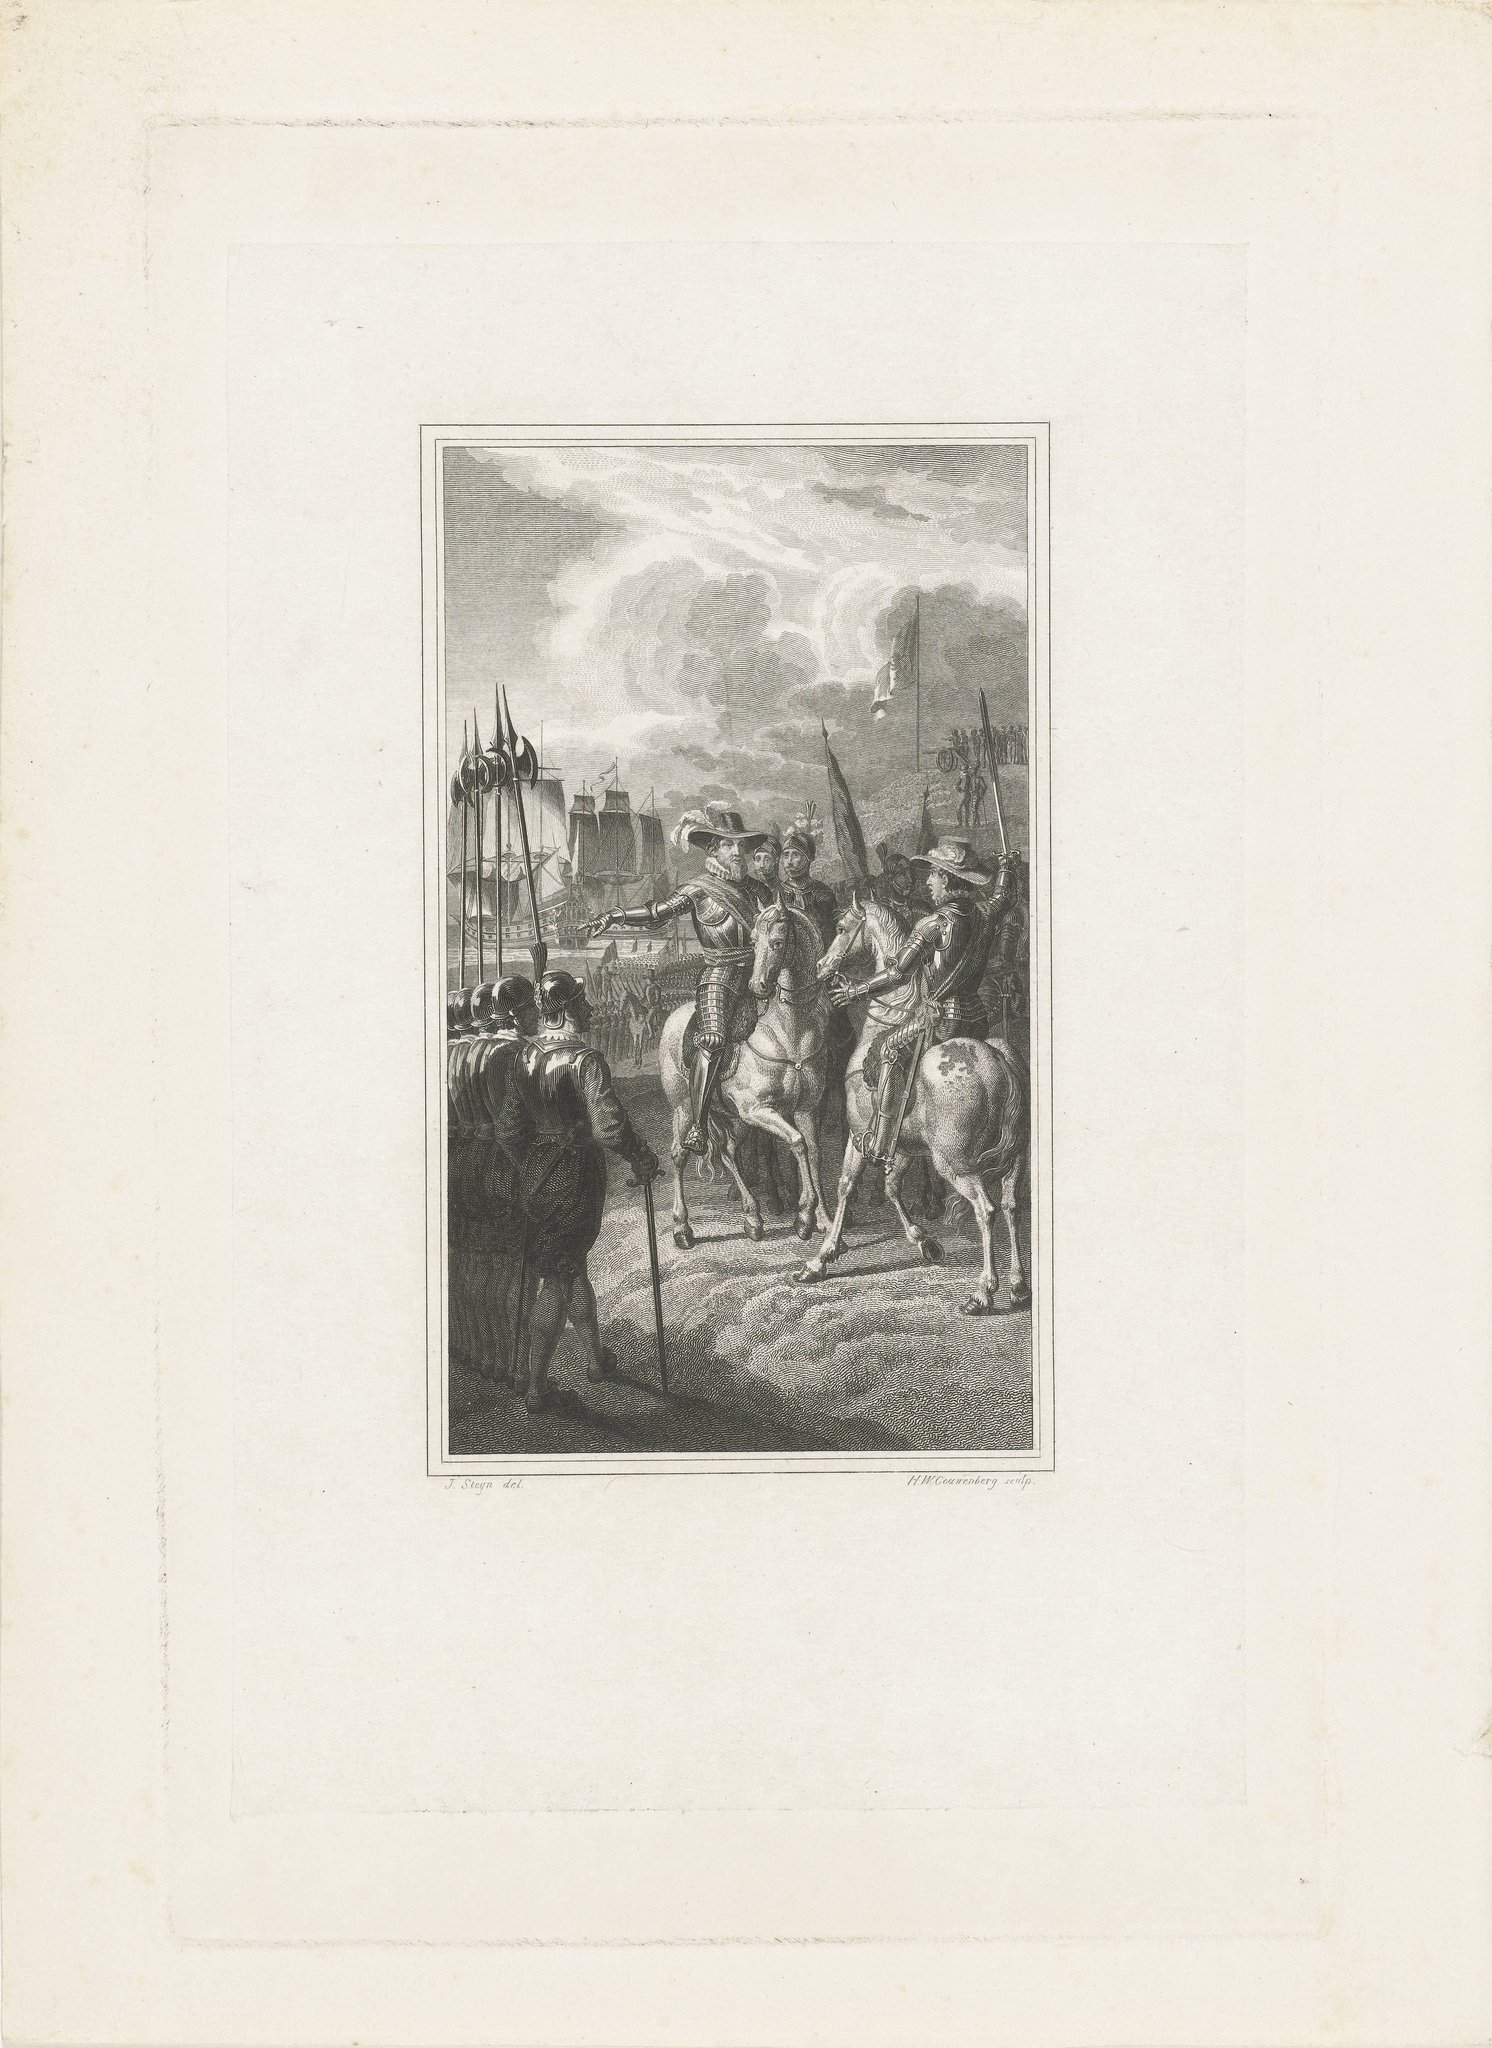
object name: print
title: Twee legeraanvoerders te paard in bespreking voor het gevecht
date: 1830-1845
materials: paper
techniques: engraving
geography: amsterdam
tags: address by general before the battle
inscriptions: collector's mark: Lugt 2228